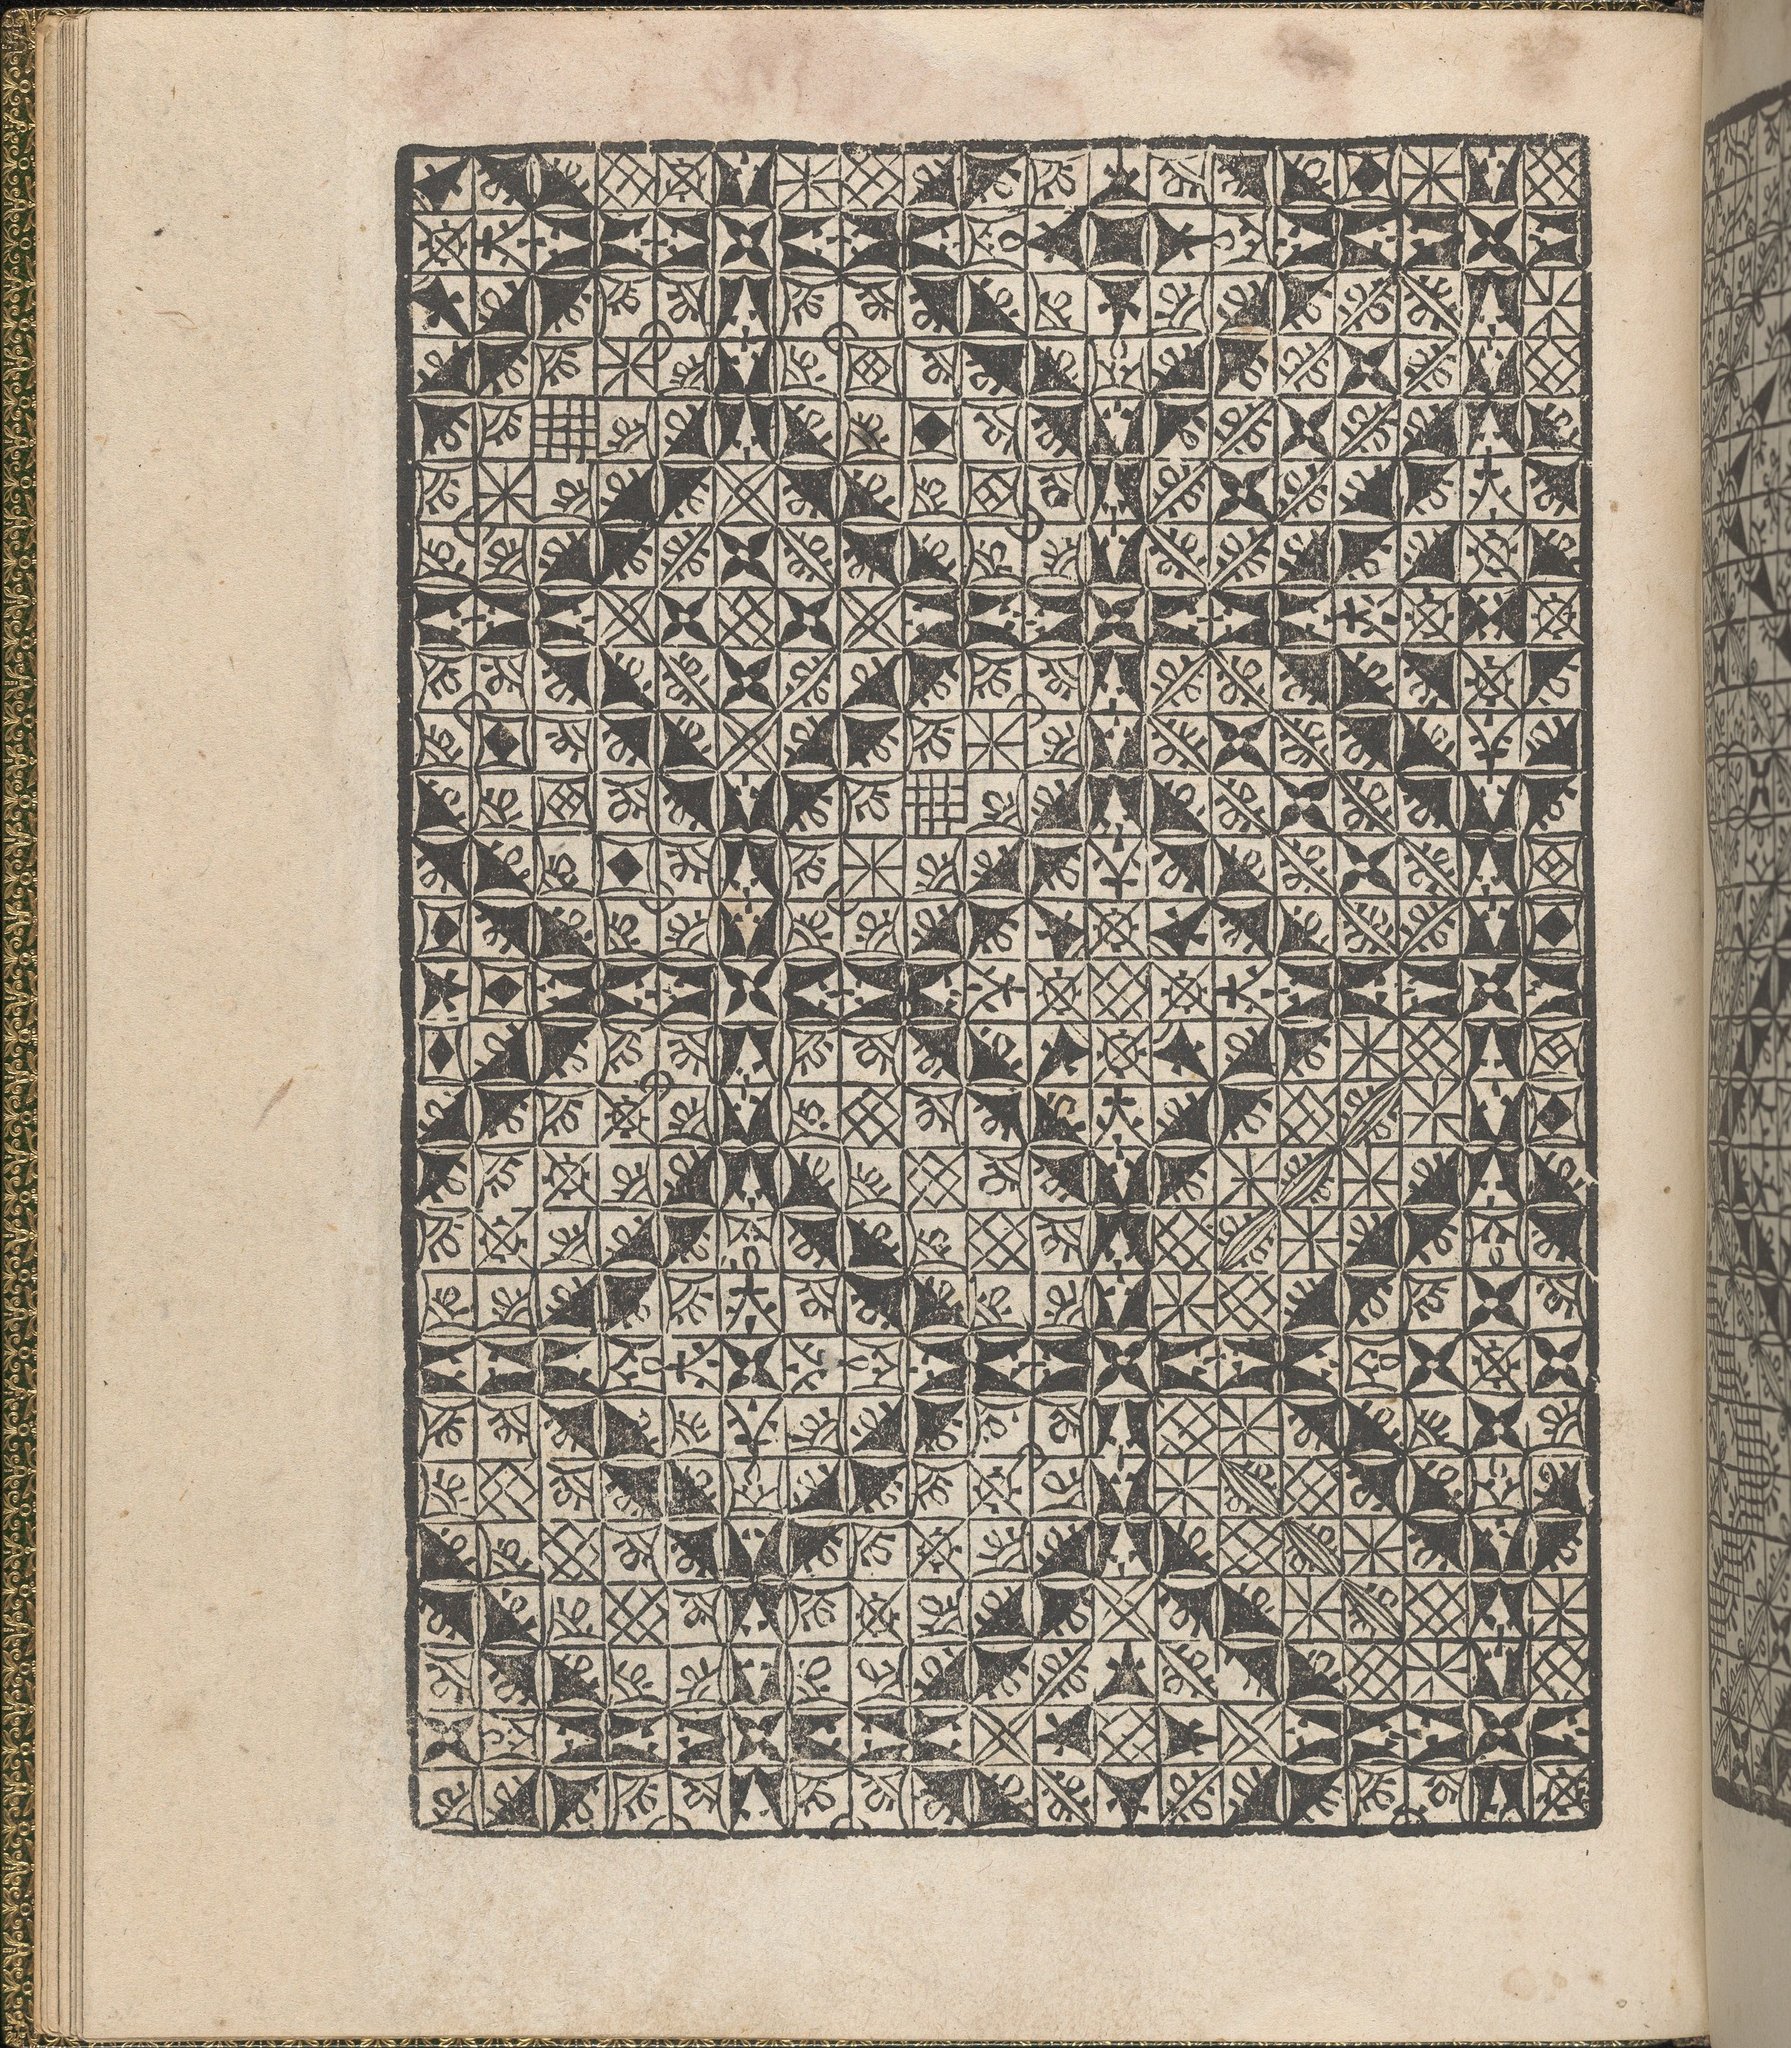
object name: book print ornament architecture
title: Giardineto novo di punti tagliati et gropposi per exercitio & ornamento delle donne (Venice 1554), page 16 (verso)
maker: matteo pagano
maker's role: publisher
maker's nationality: italian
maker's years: 1515-1588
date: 1554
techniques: woodcut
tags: ornament